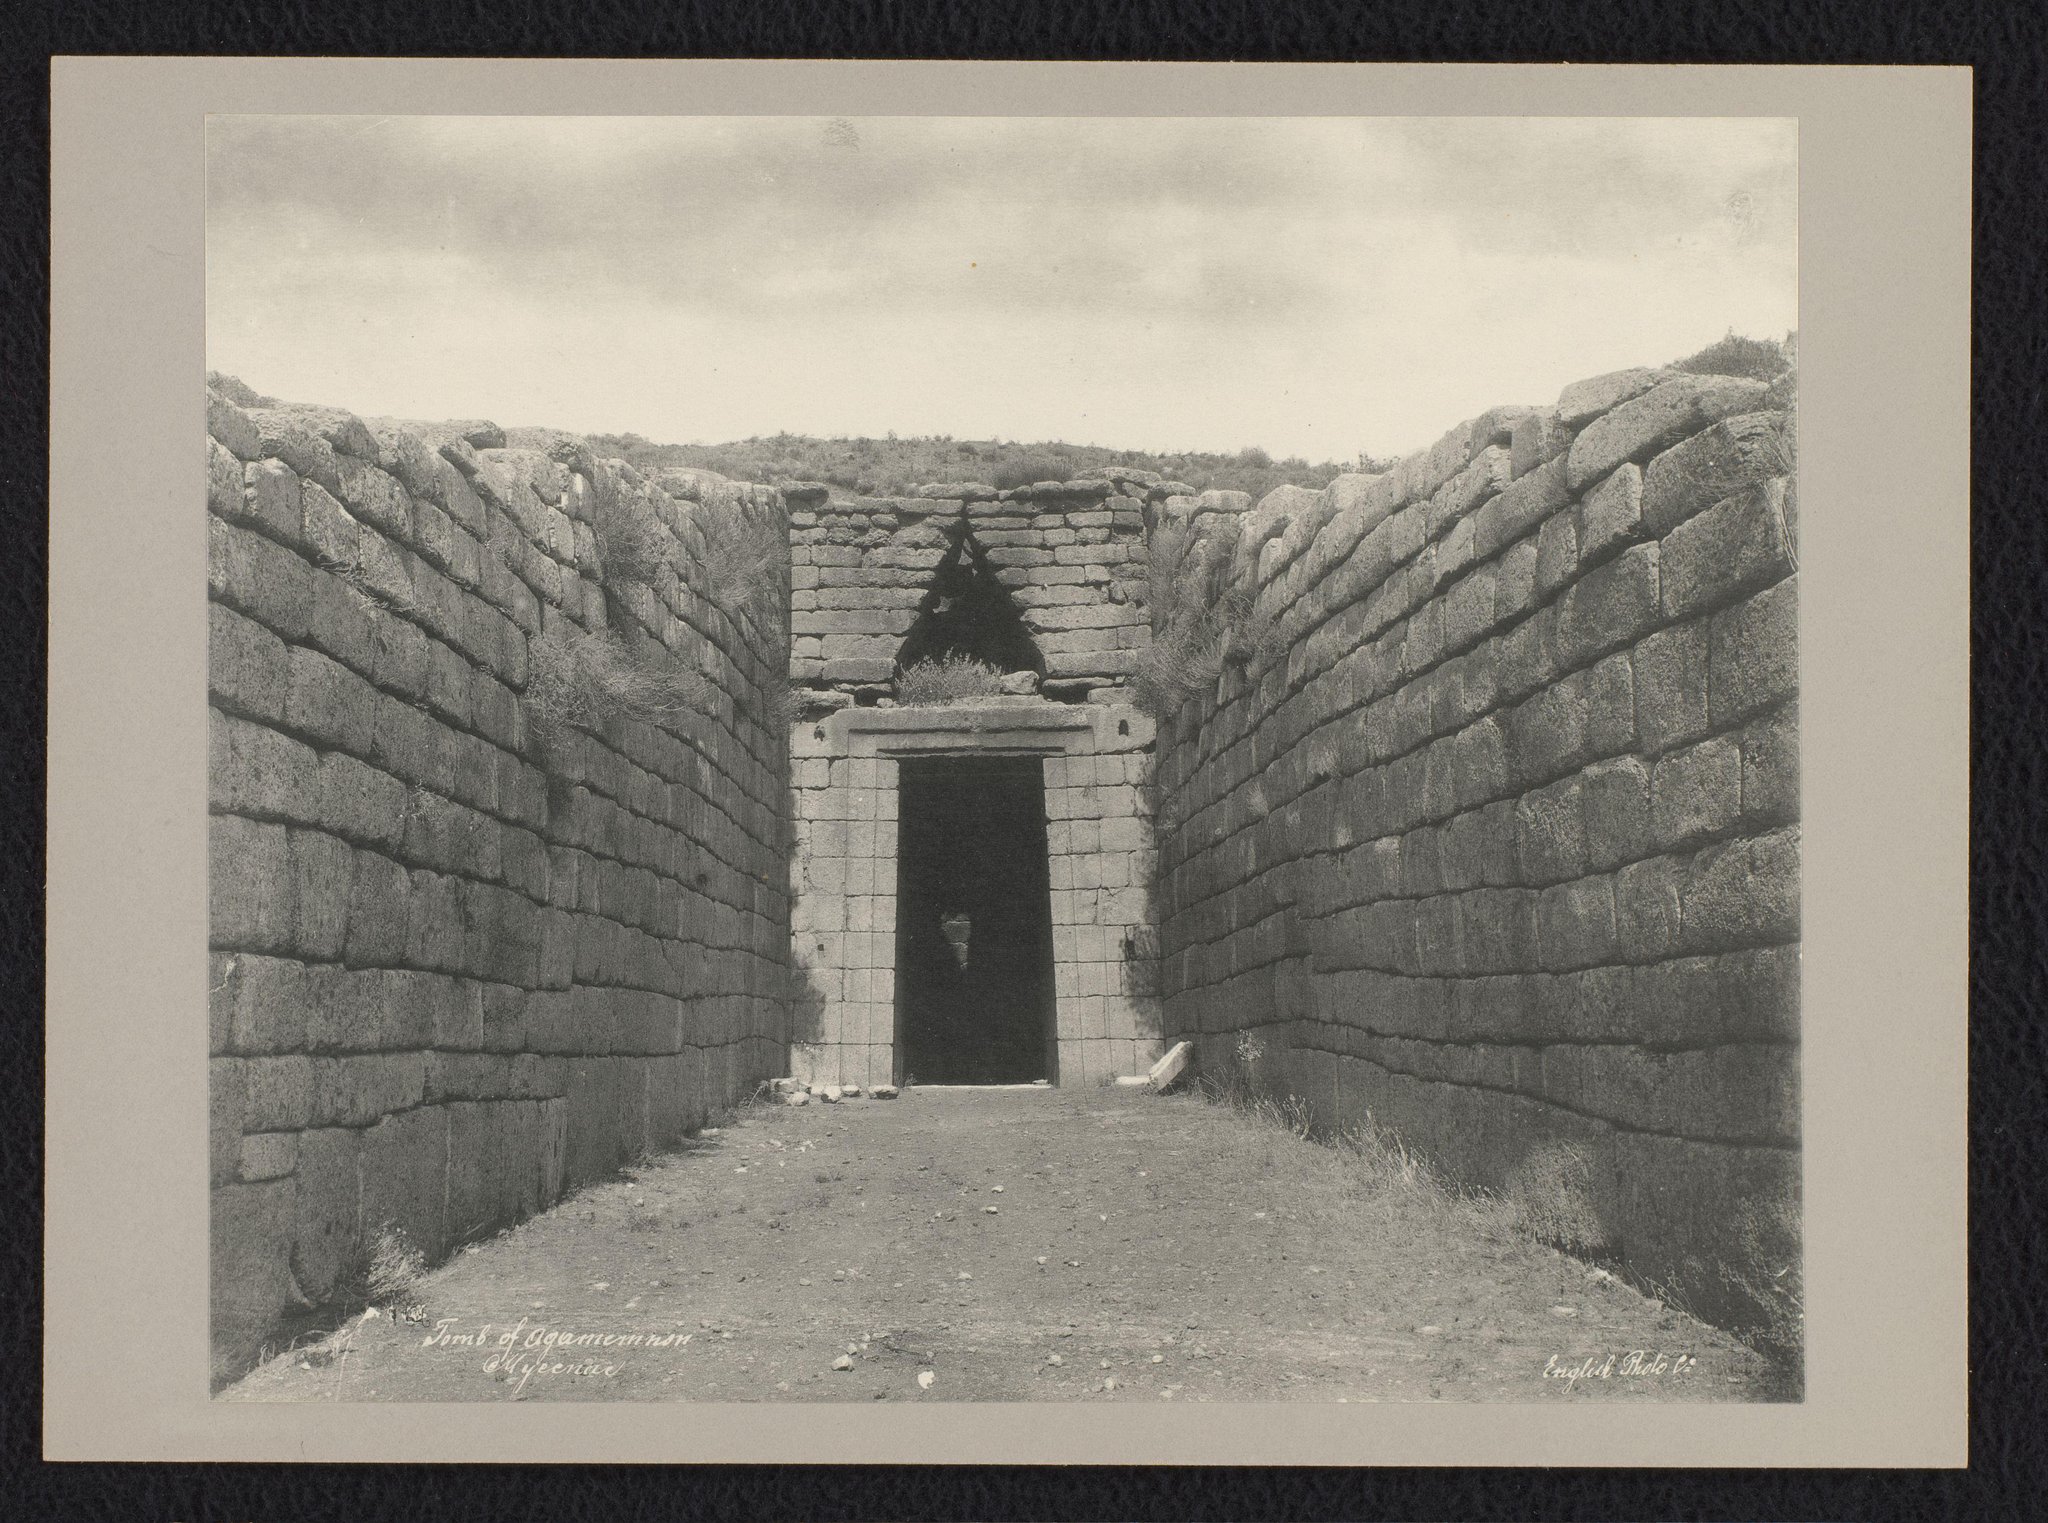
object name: photograph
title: Ingang van de tombe van Agamemnon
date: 1895-1915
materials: cardboard, paper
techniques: photograph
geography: creta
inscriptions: signature: ‘English Photo Co.’, number: ‘10.’, title: ‘Tomb of Agamemnon Mycene’